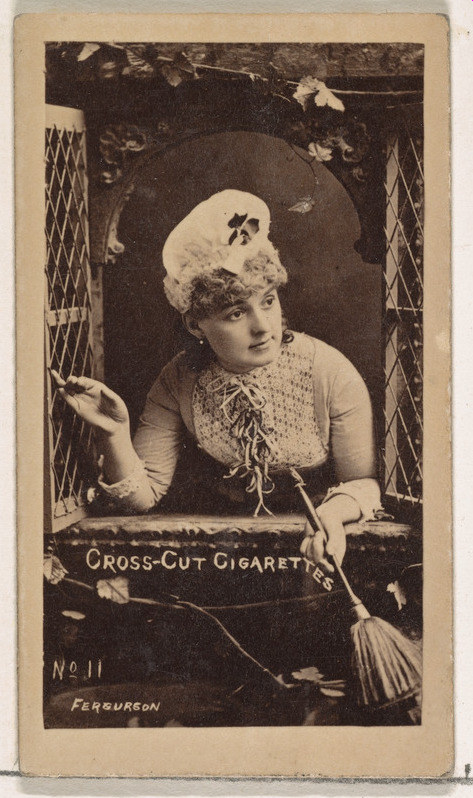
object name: print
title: Card Number 11, Fergurson, from the Actors and Actresses series (N145-1) issued by Duke Sons & Co. to promote Cross Cut Cigarettes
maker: w. duke, sons & co.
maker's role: publisher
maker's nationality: american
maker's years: 1870-1920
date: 1880-1889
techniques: albumen silver print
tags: portraits,women,actresses